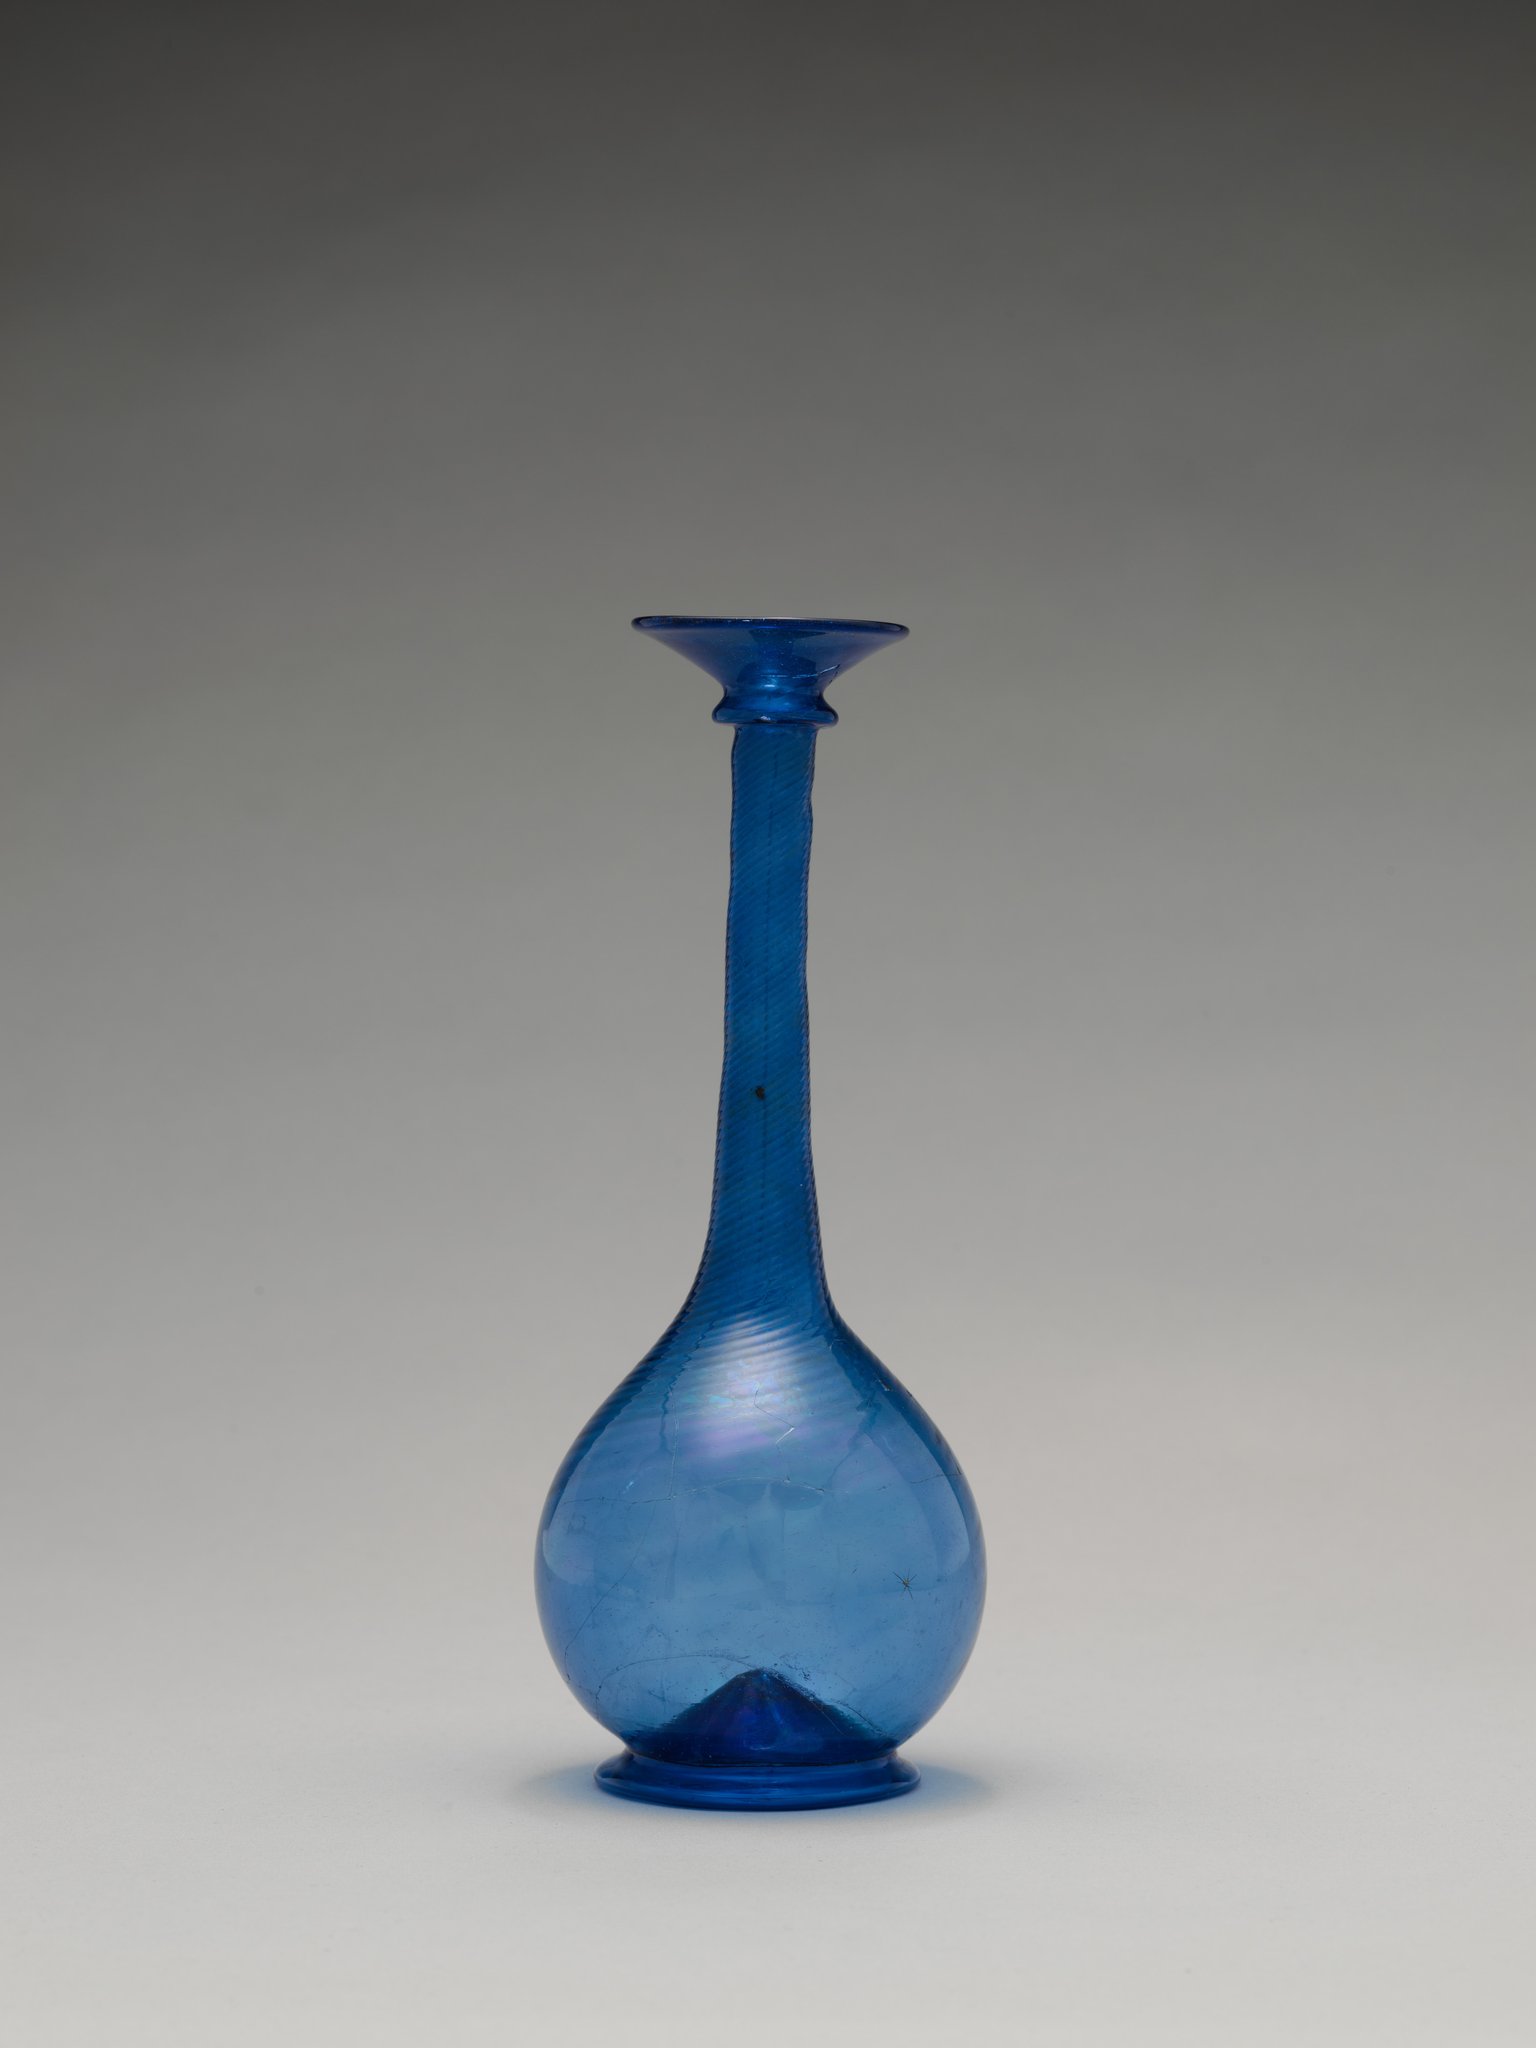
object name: bottle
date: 1701-1900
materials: glass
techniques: glassblowing, tooling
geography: iran